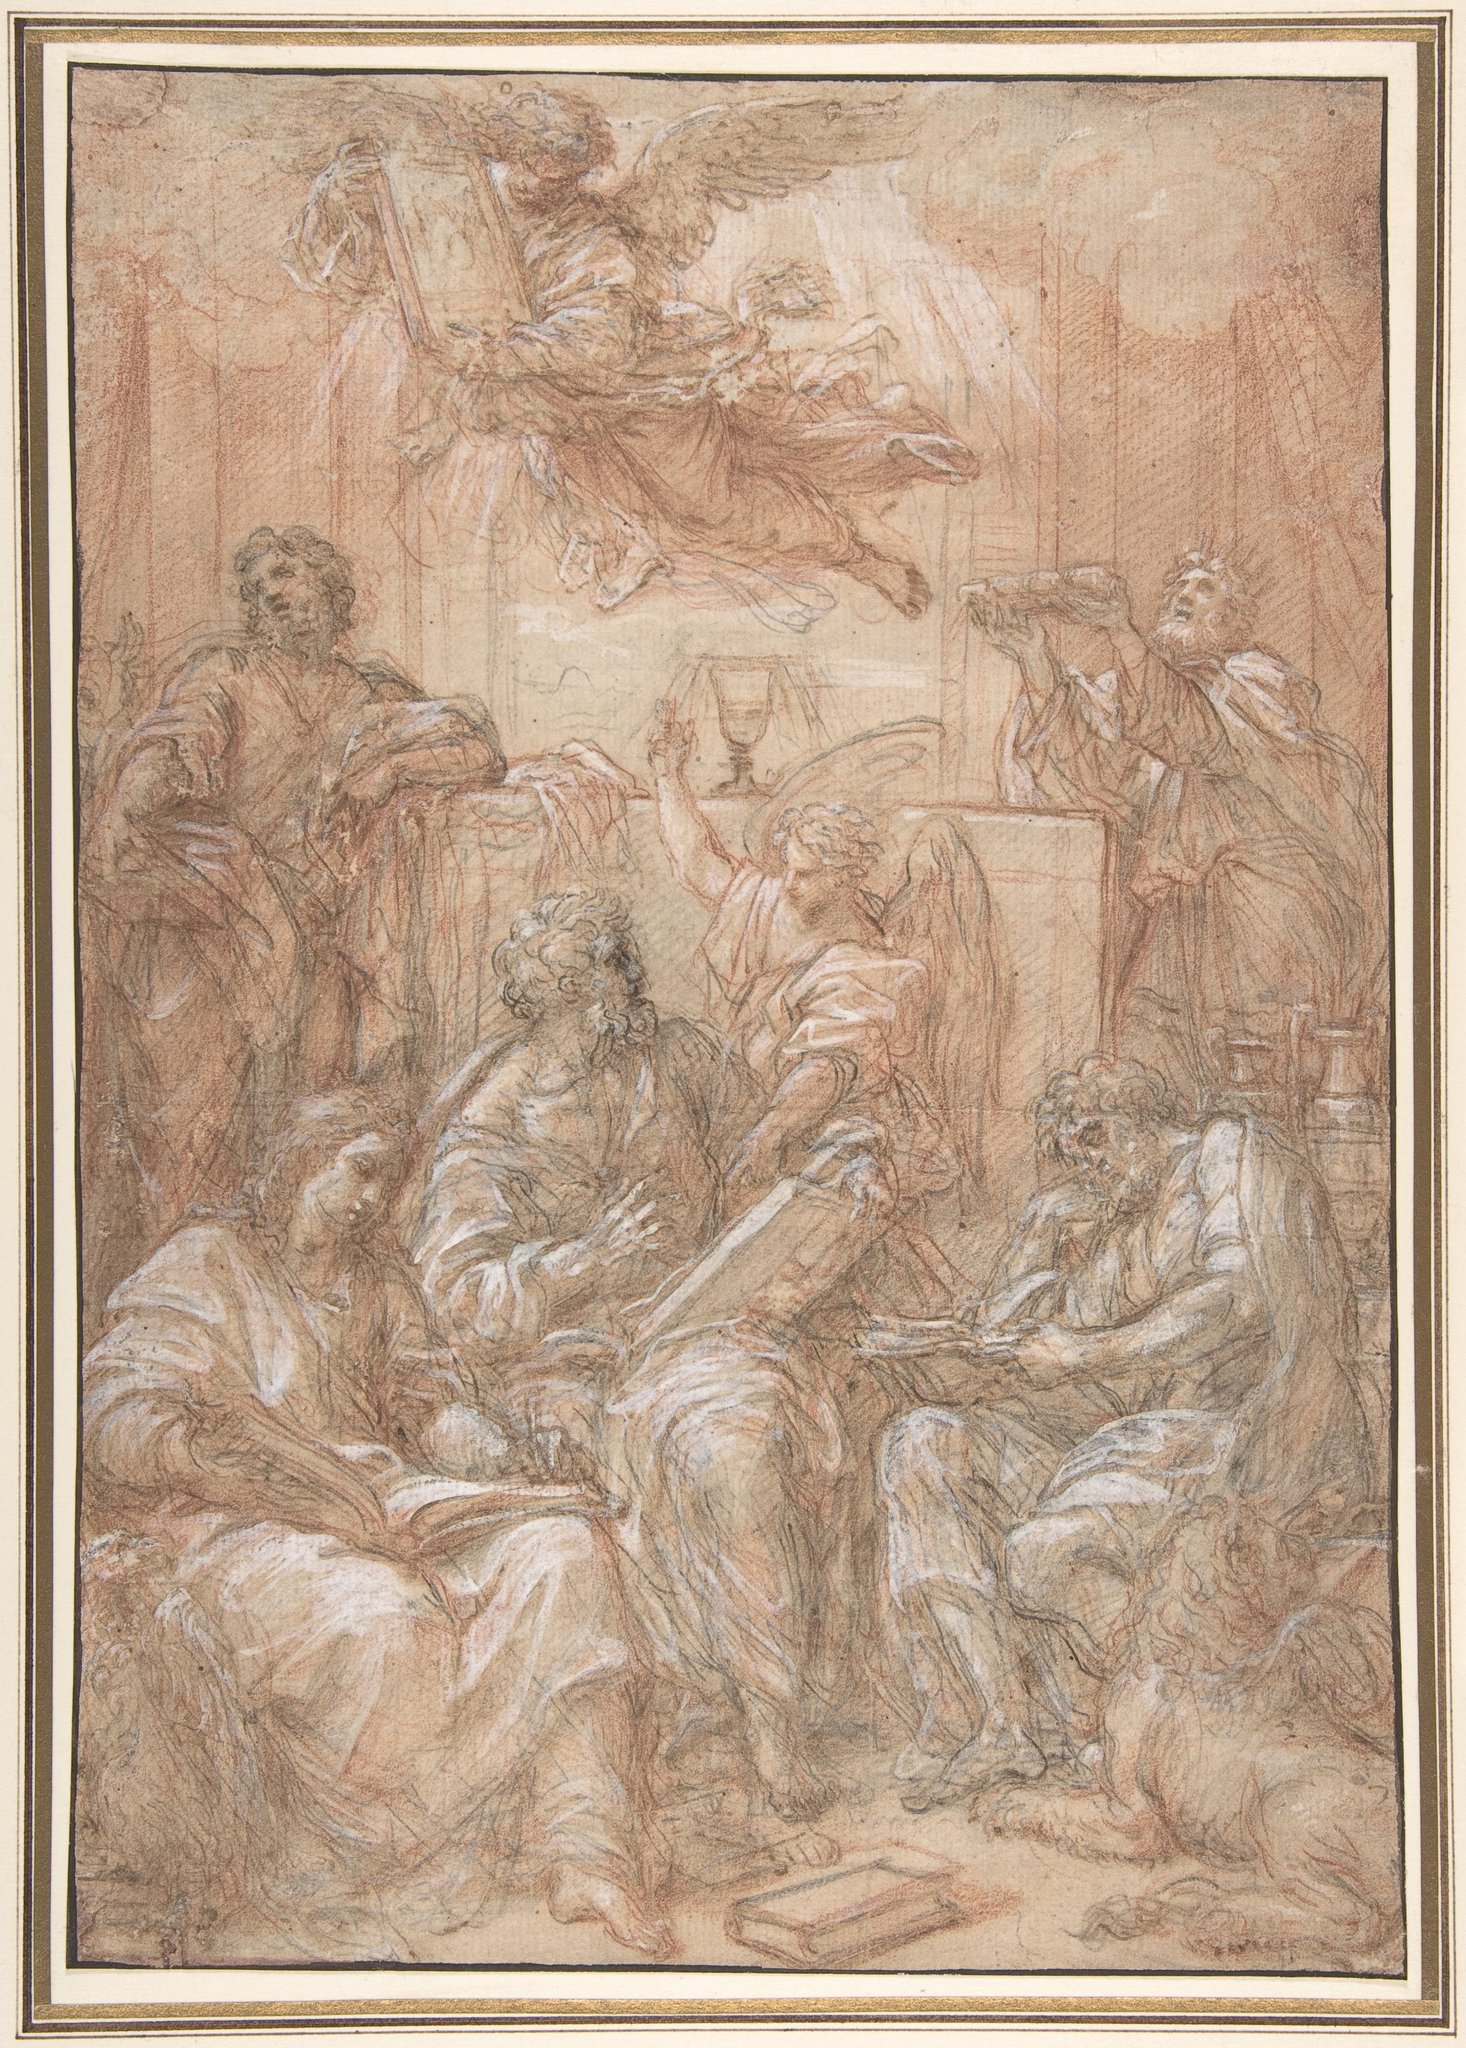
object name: drawing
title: Allegory of the Old and New Dispensations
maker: carlo maratti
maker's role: artist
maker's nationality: italian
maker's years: 1625-1713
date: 1700-1708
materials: chalk, gouache, ink, paper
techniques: highlighting, pen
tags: animals,men,angels